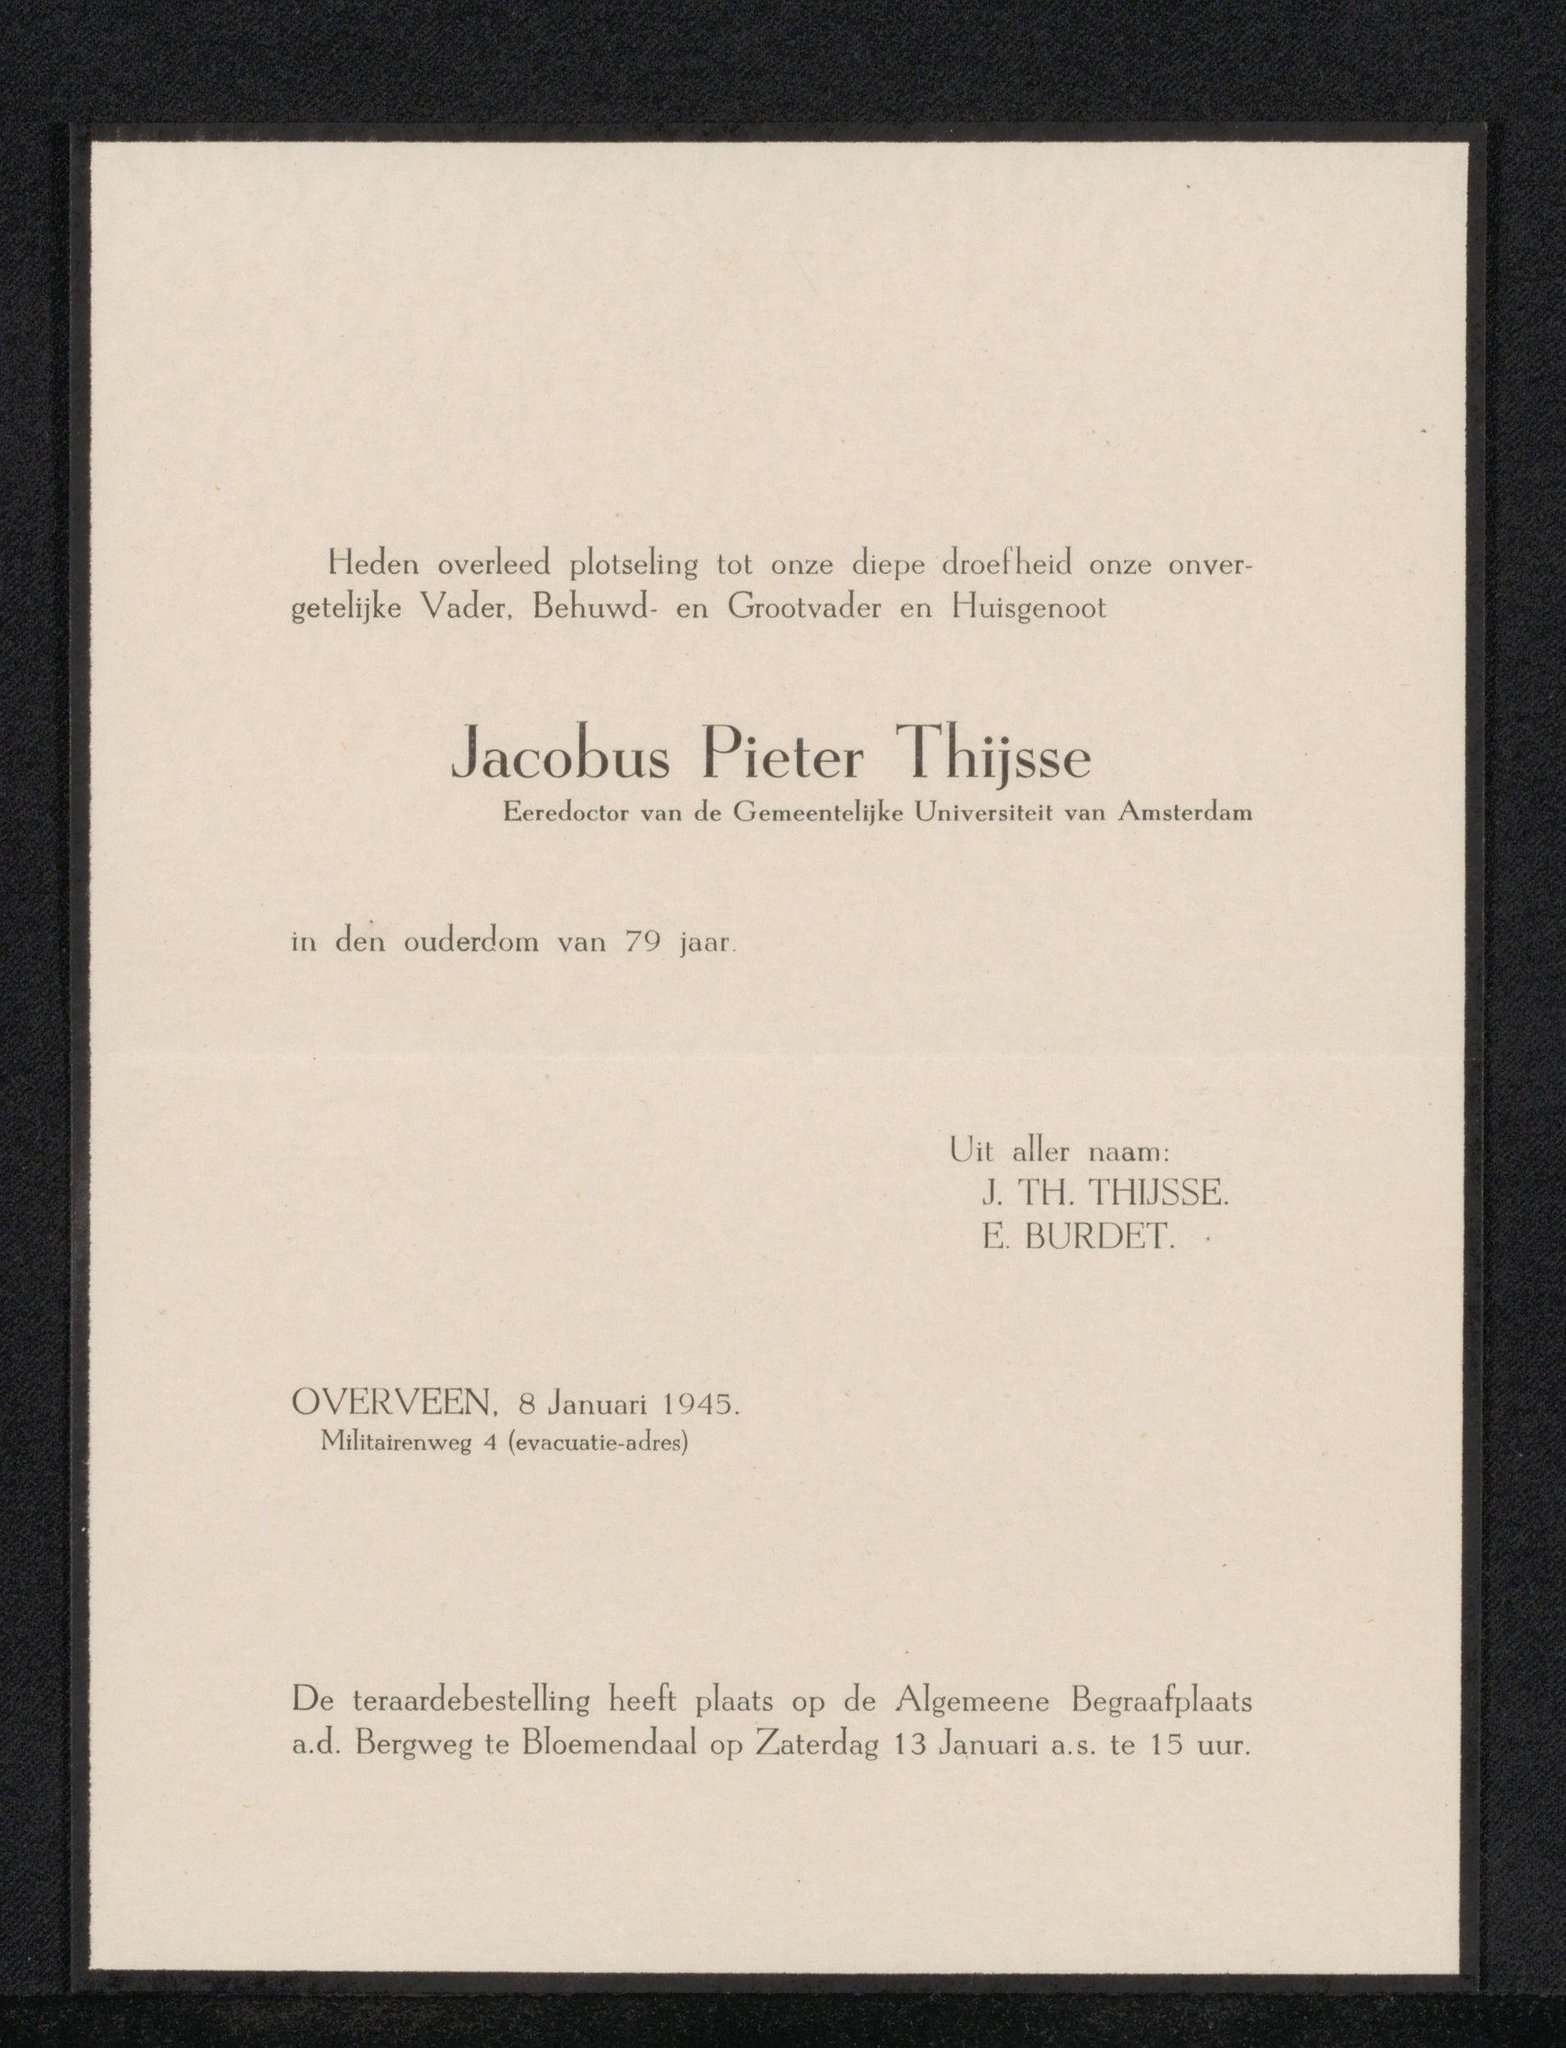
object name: overlijdensbericht, overlijdensadvertentie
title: Overlijdensbericht aan mevrouw Kuperus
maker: Anonymous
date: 1945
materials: paper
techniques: printing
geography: overveen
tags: maastricht, jac. p. thijsse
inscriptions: collector's mark: ‘RPK’